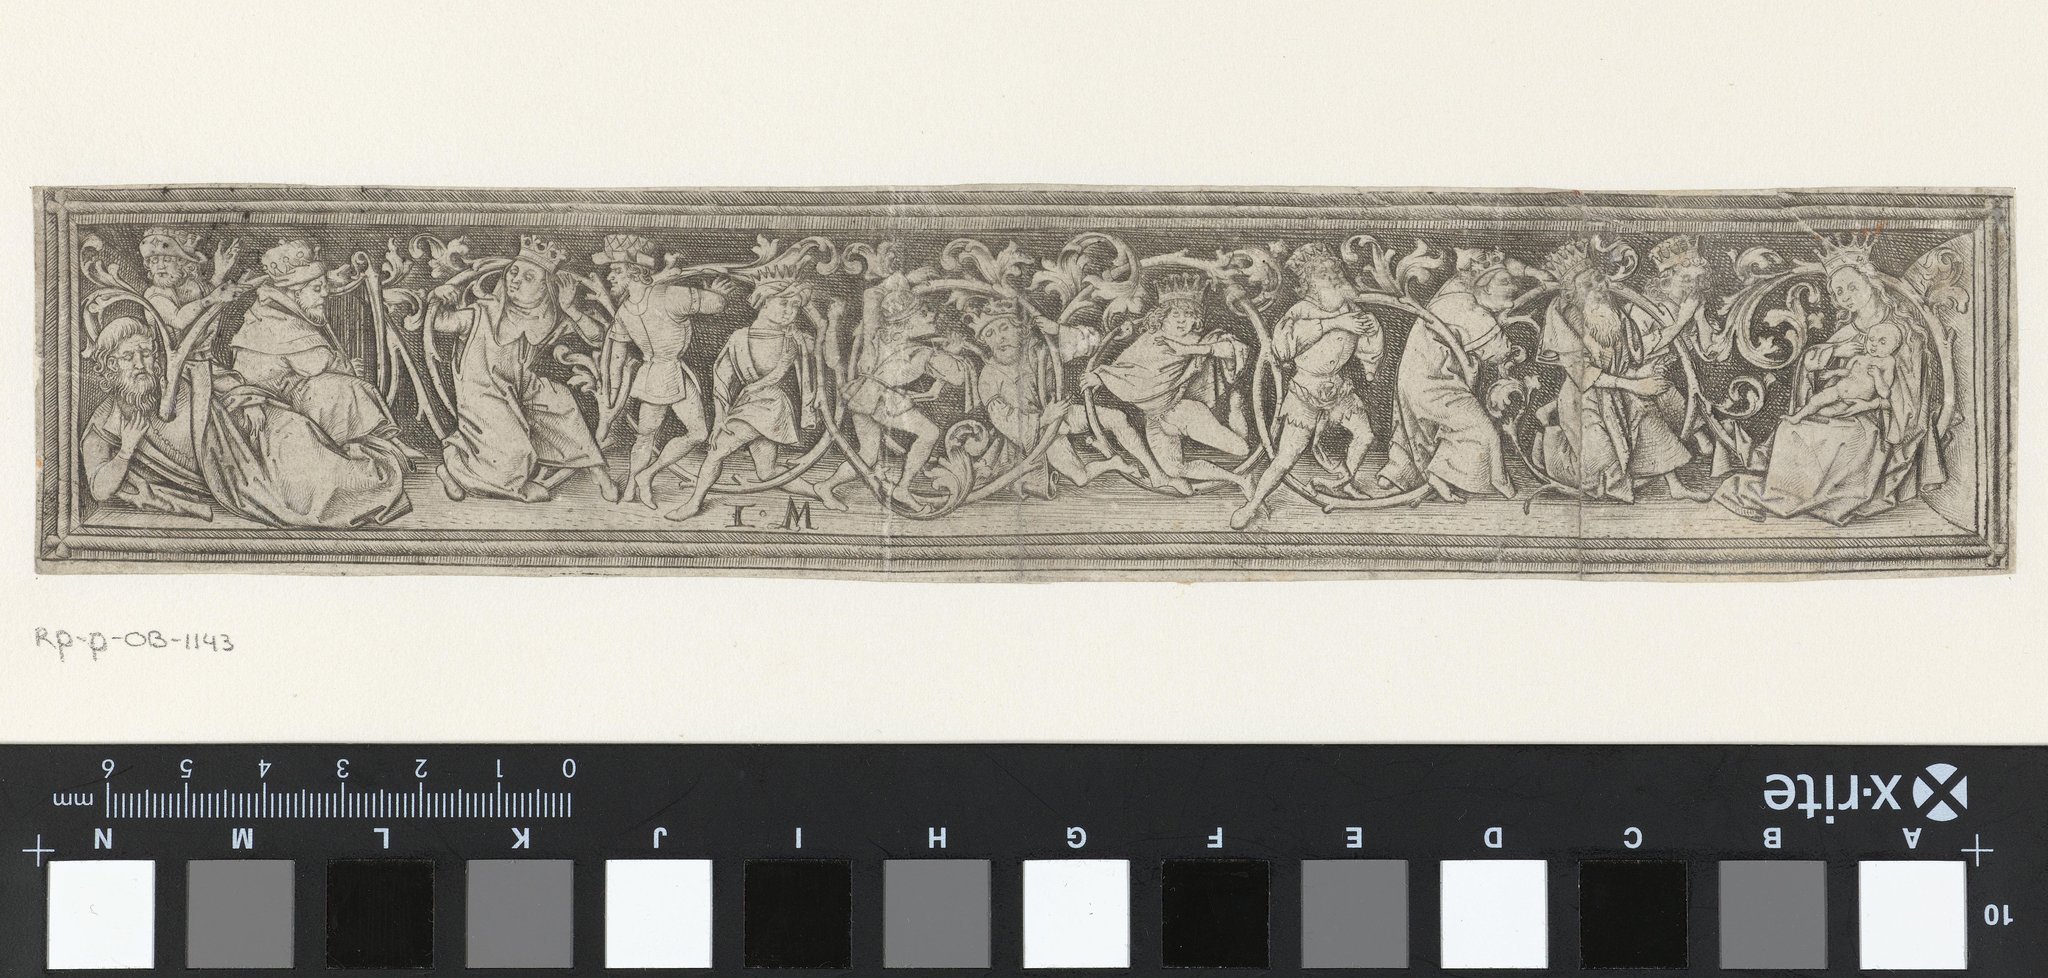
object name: print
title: Tree of Jesse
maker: israhel van meckenem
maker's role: print maker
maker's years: 1440-1517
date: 1455-1503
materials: paper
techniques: engraving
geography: bocholt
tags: tree of jesse: genealogical tree showing christ's ancestors, sprouting from jesse's loins, plants; vegetation (+ ornamental variants of plants)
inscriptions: collector's mark: Lugt 240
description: Friesvormige voorstelling van een slapende man (Jesse, uiterst links) uit wie een boom groeit in de vorm van een lange rank. Tussen de bladeren verschillende gekroonde figuren, onder wie koning David met zijn harp (links) en Maria met het Christuskind (uiterst rechts). Pendant van een ornamentprent met hazen die een jager braden.